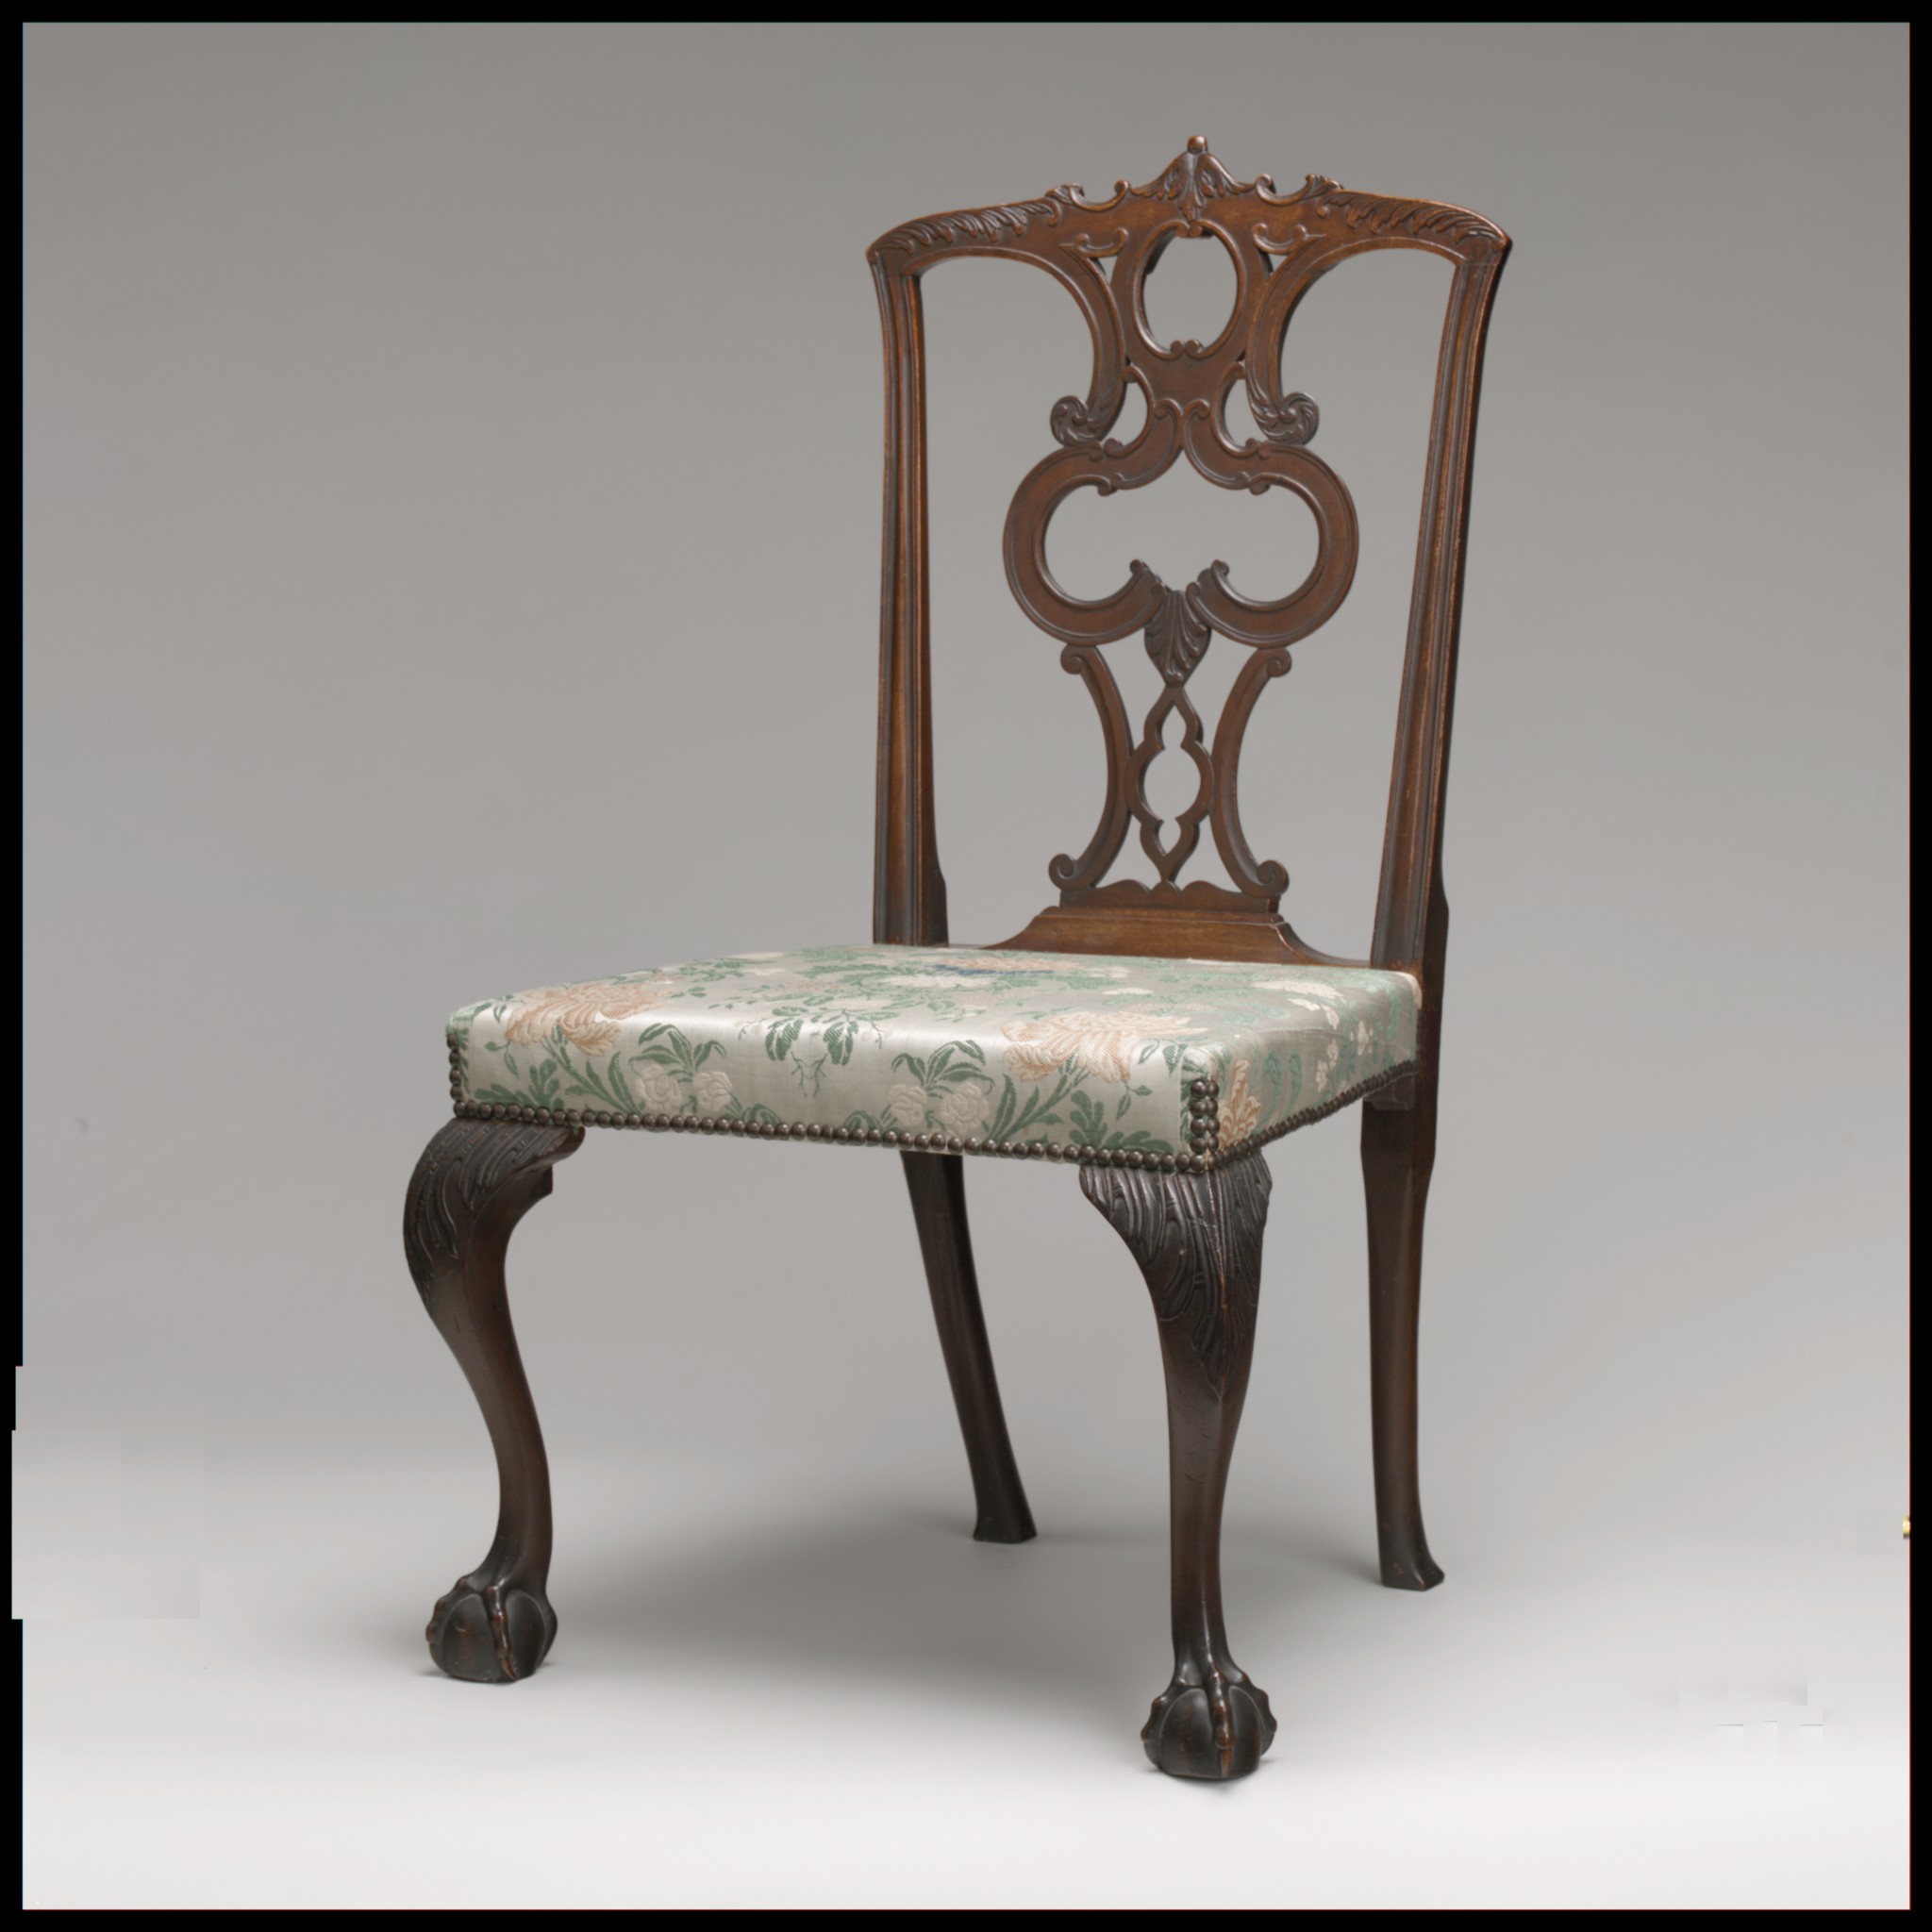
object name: side chair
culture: american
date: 1765-1790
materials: wood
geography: united states